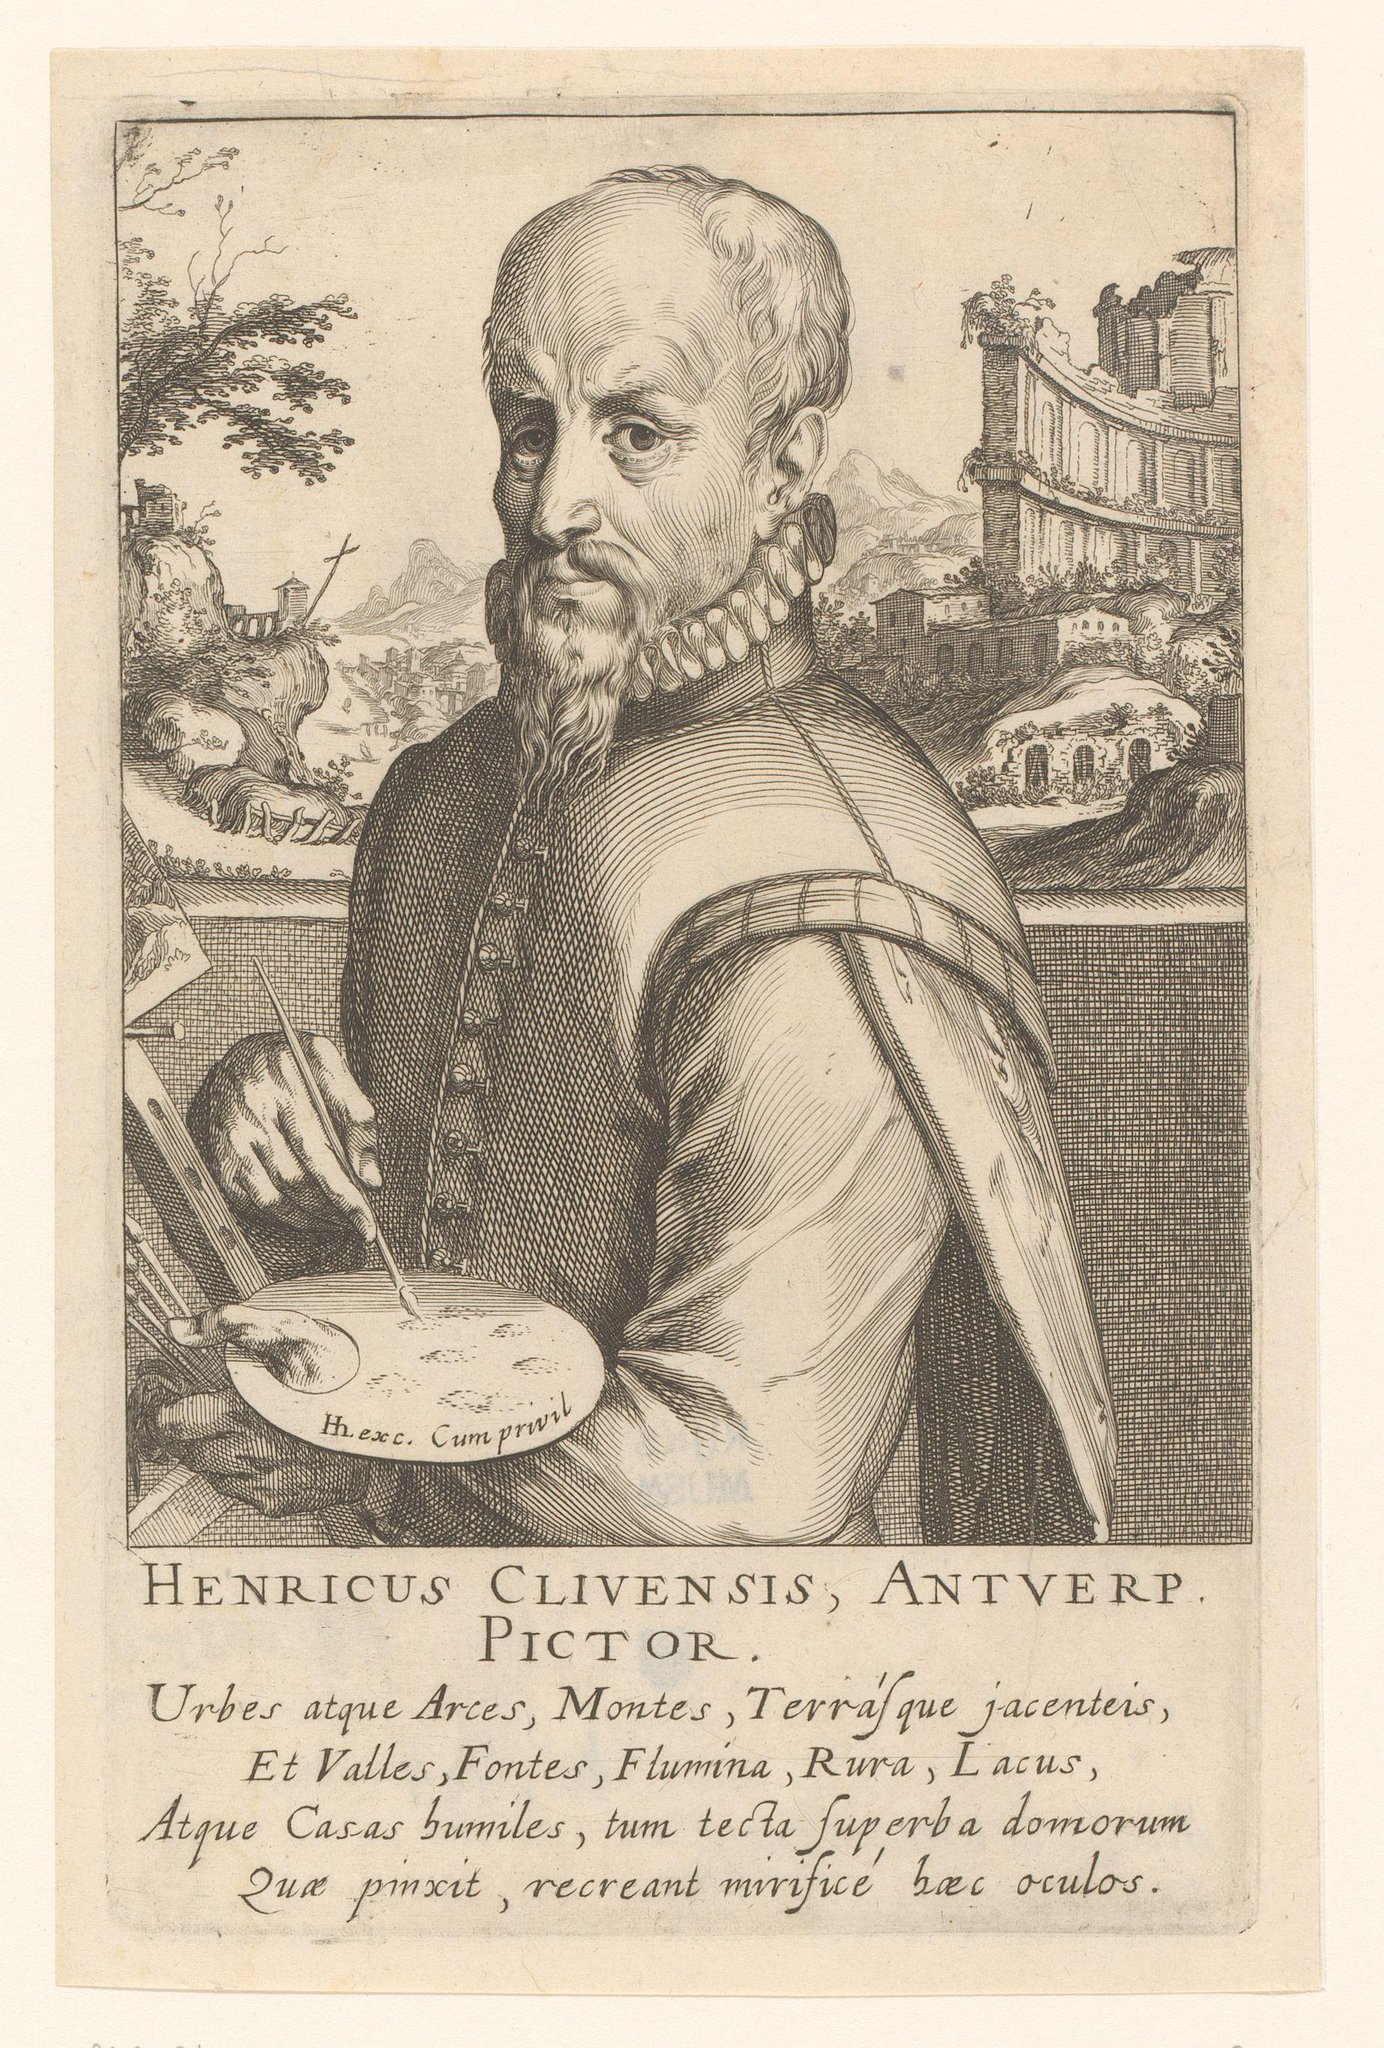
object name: print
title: Henricus Clivensis, Antverp Pictor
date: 1610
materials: paper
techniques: engraving, etching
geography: the hague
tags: print maker, draughtsman, hendrick van cleve, historical persons, portrait, self-portrait of painter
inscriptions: collector's mark: Lugt 2166, collector's mark: Lugt 2760